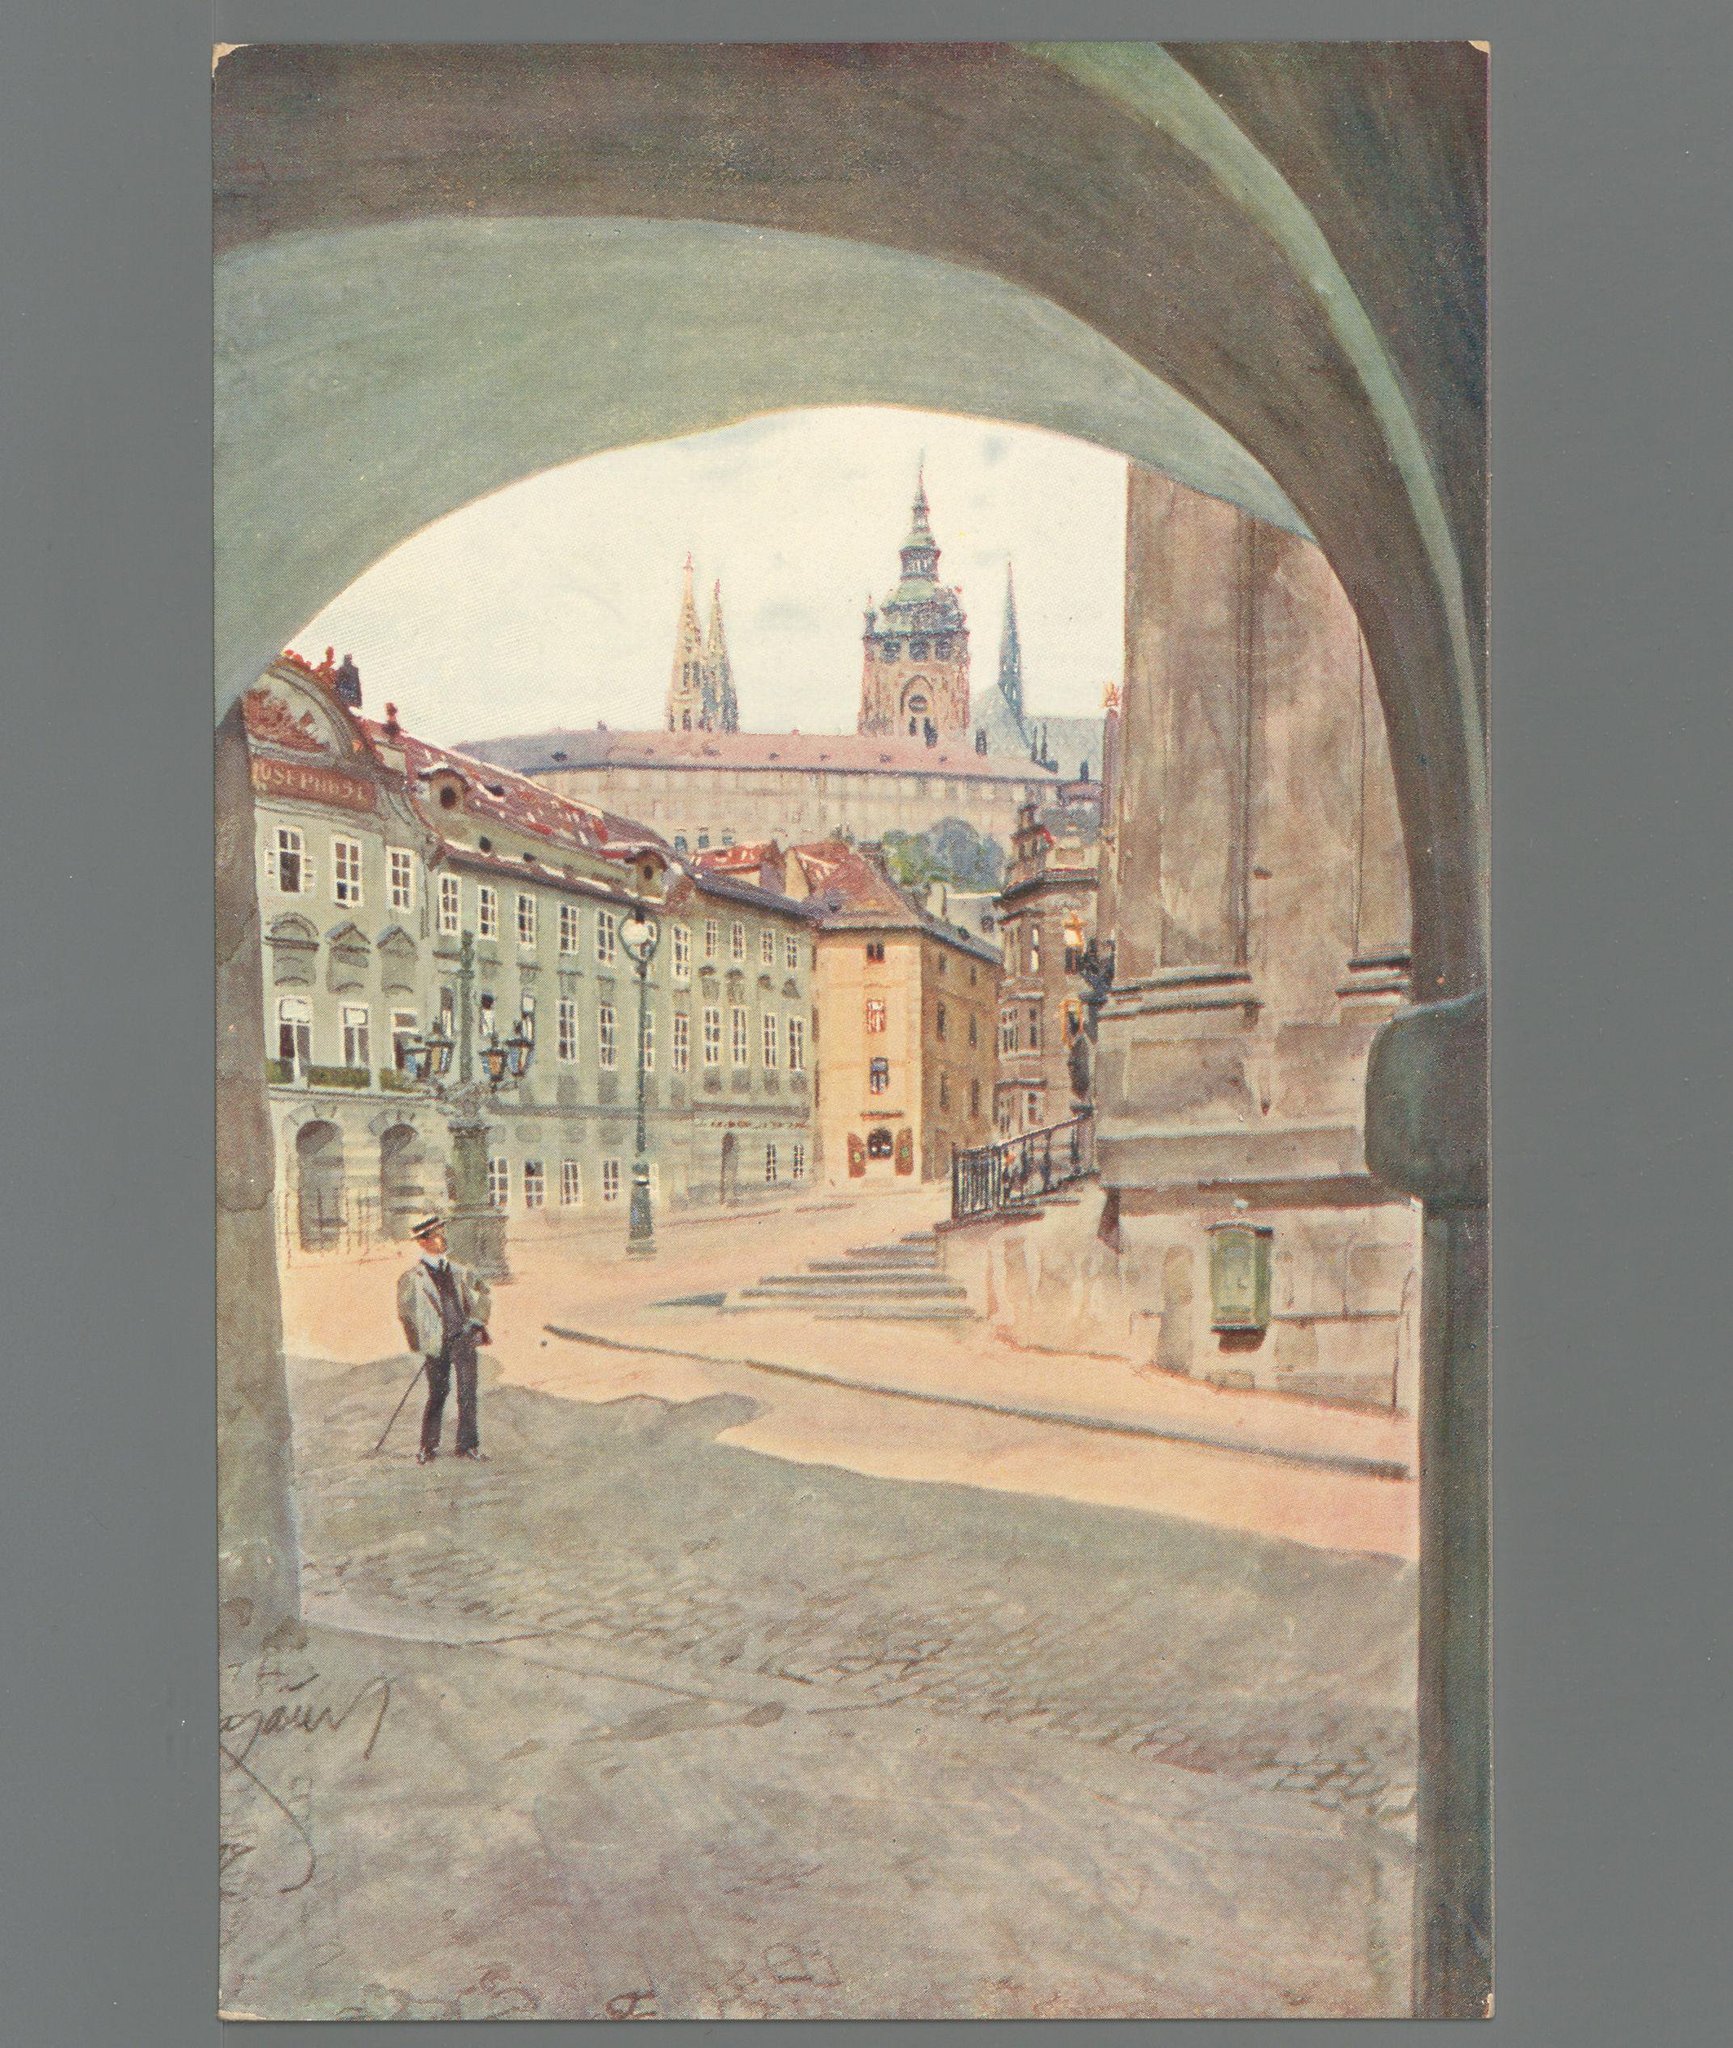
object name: reproduction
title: Praha. Malostranské námestí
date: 1906-1930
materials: cardboard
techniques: color autotype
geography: prague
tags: square, place, circus, etc., gate, entrance, prague